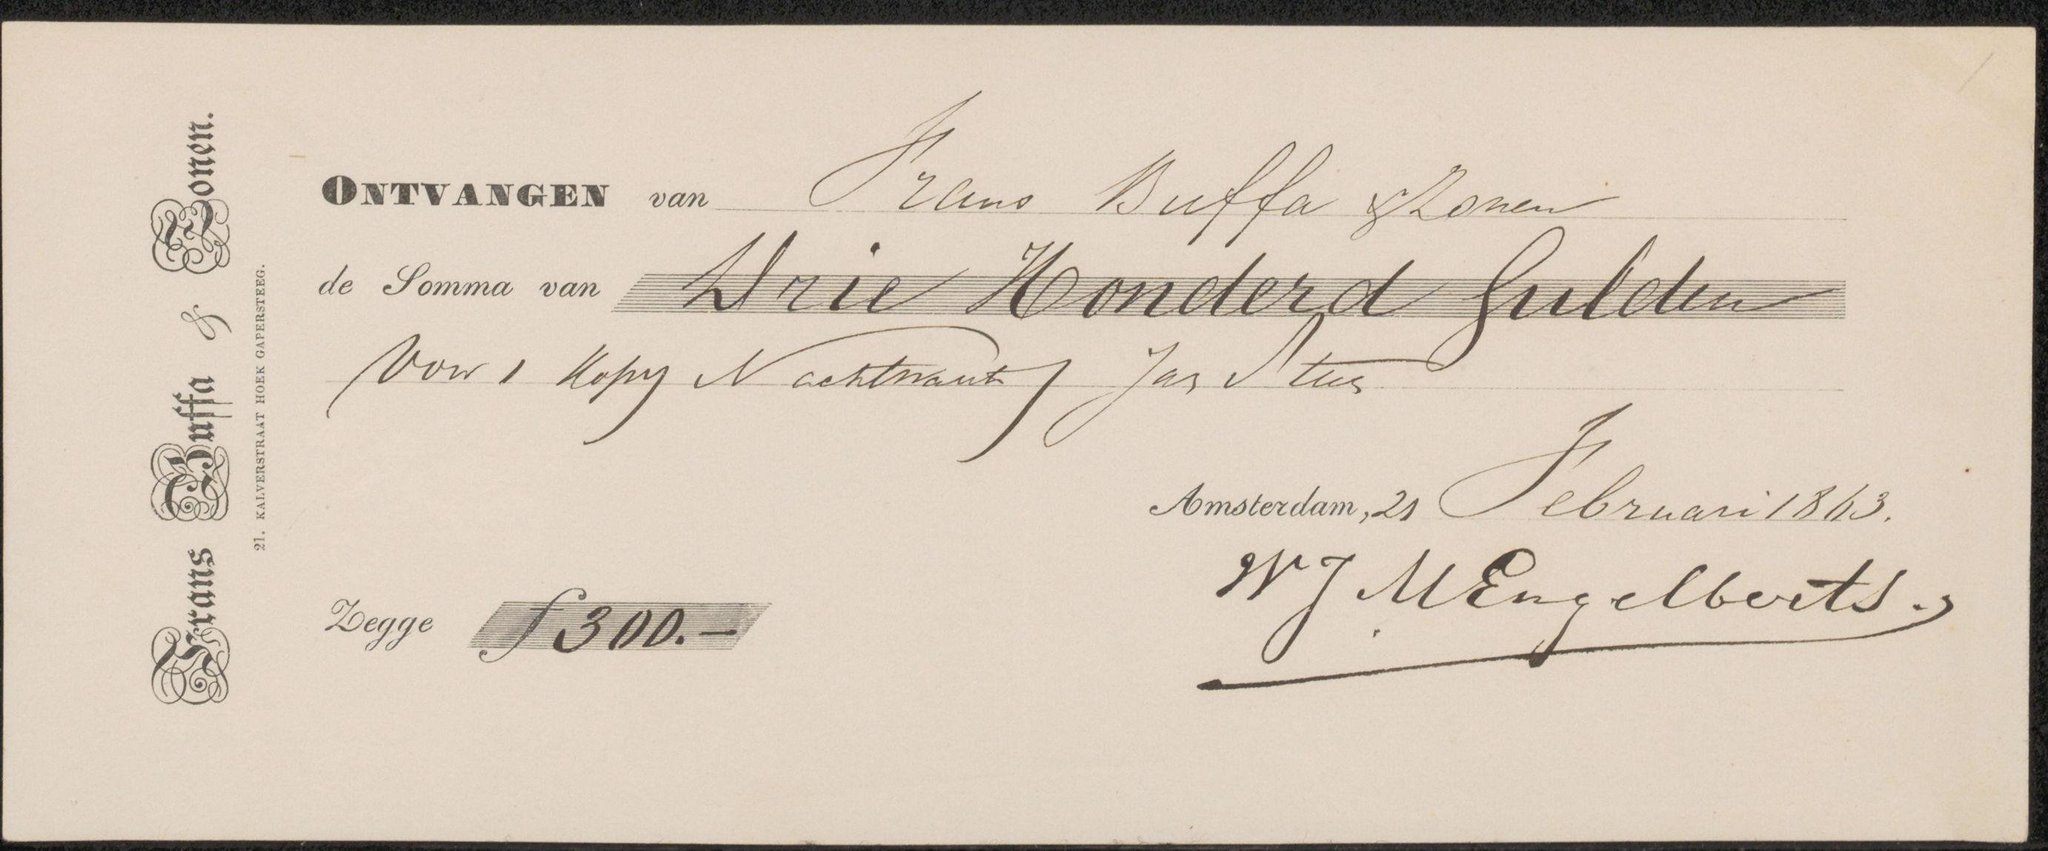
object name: ontvangstbewijs, kwitantie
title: Kwitantie voor Willem Jodocus Mattheus Engelberts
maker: willem jodocus mattheus engelberts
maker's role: draughtsman, print maker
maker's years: 1809-1887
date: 1863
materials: ink, paper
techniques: pen, printing, writing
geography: amsterdam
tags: painting (including book-illumination, miniature-painting), money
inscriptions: collector's mark: Lugt 2233